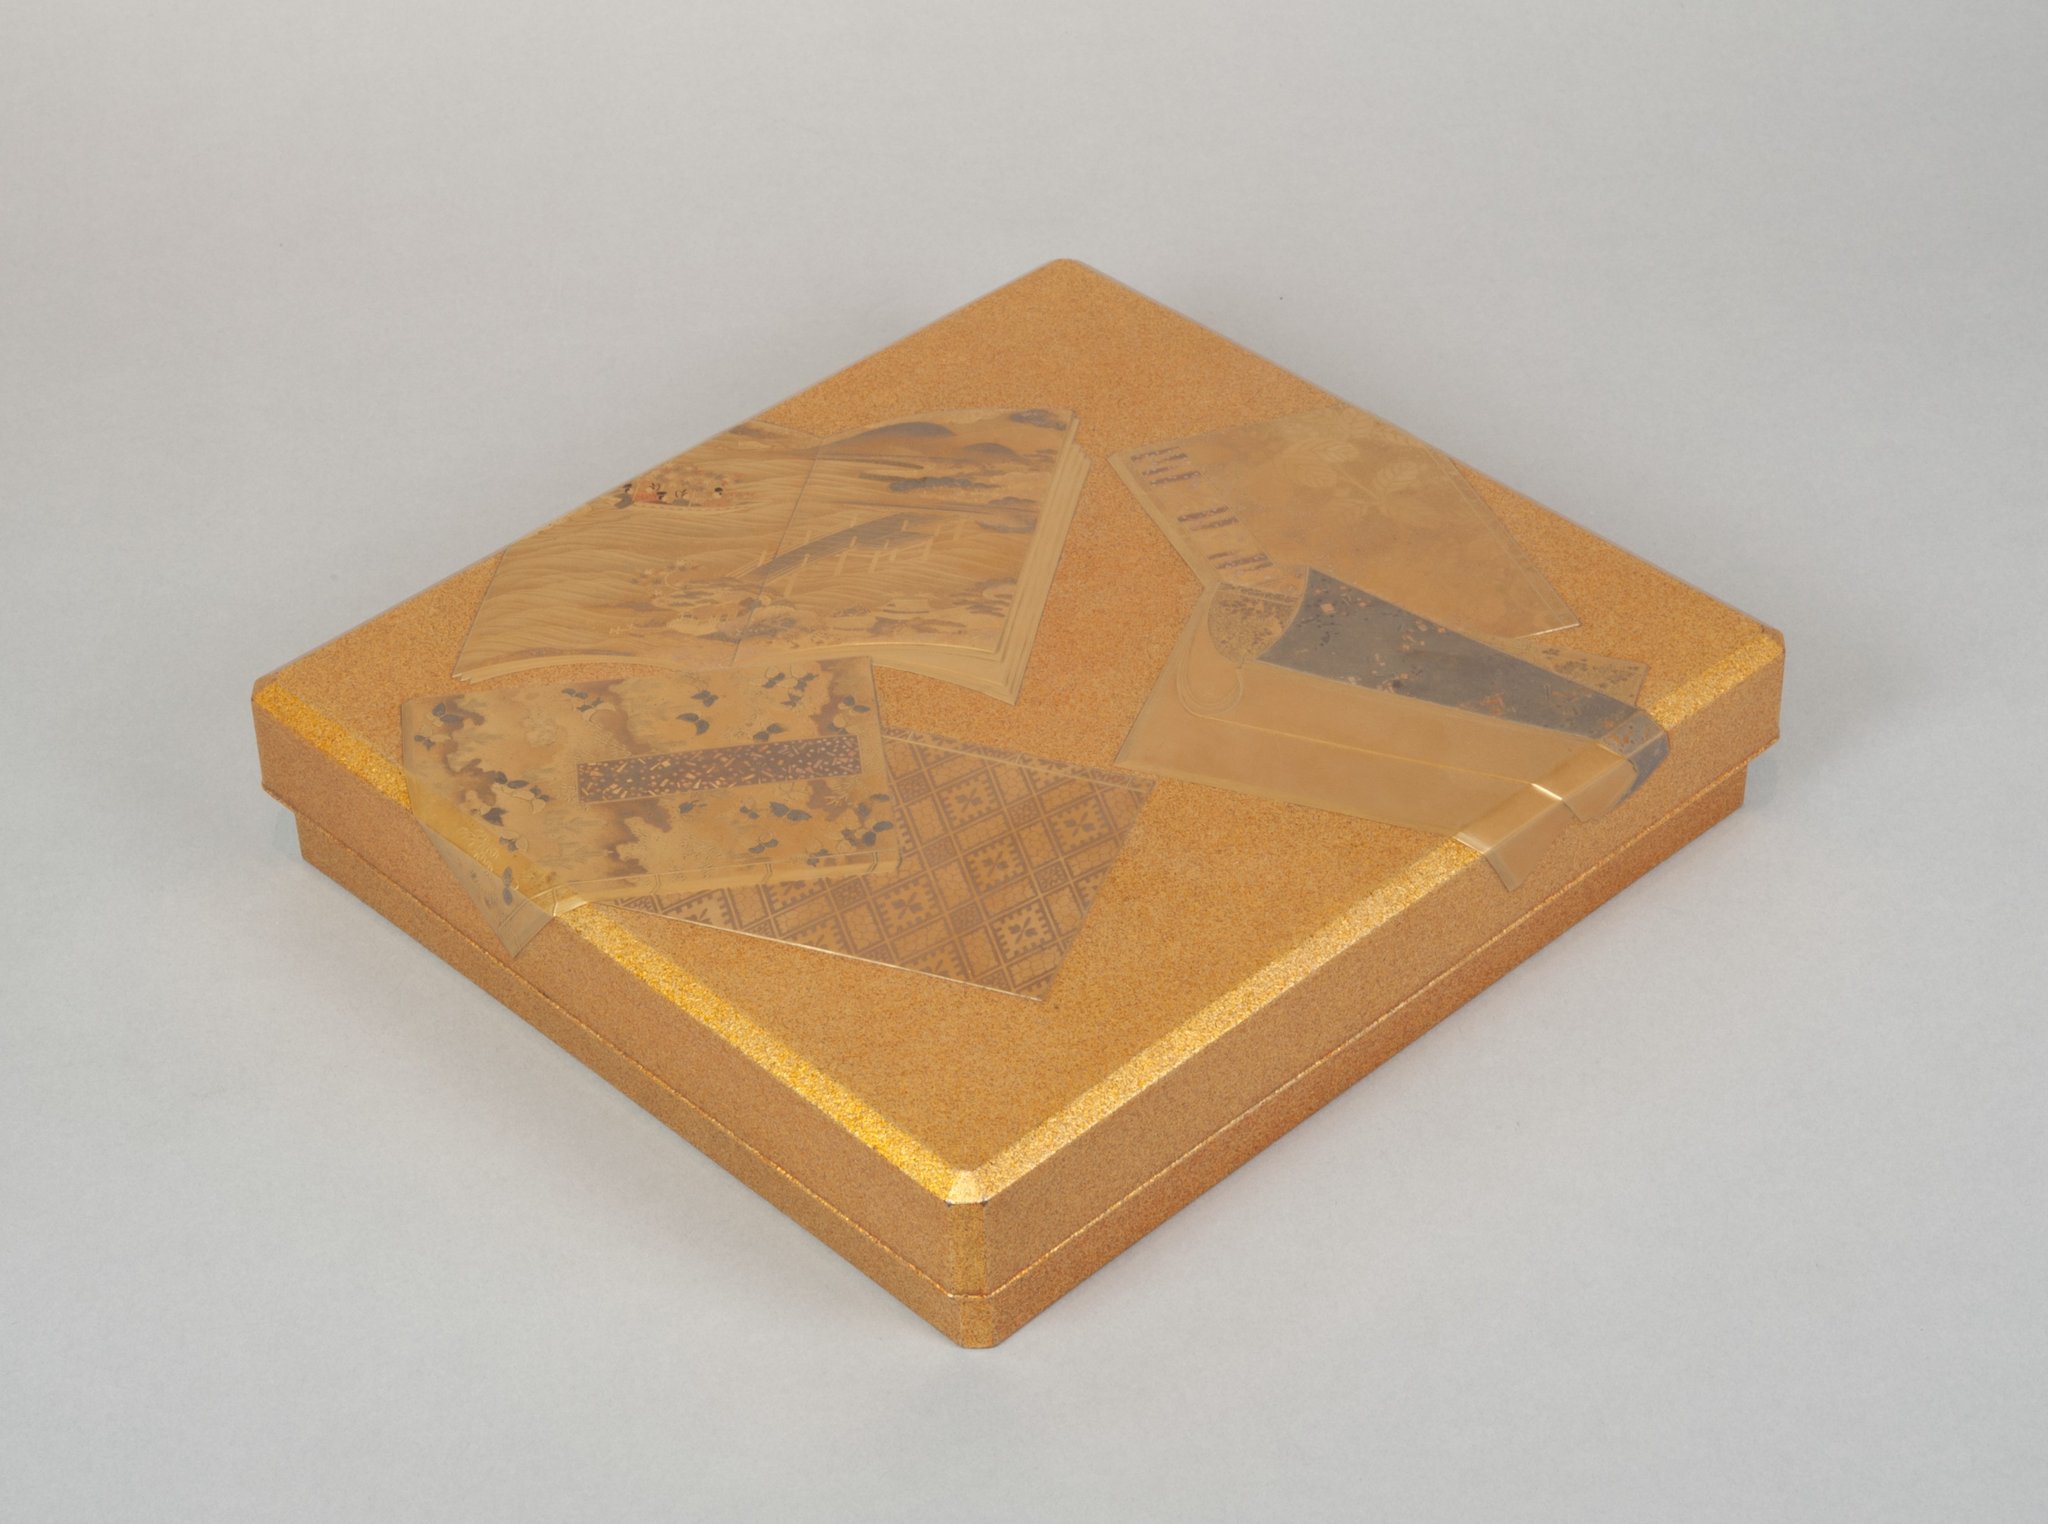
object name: writing box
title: Writing Box with Illustrated Books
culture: japanese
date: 1801-1900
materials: gold, lacquer, silver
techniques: maki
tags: books